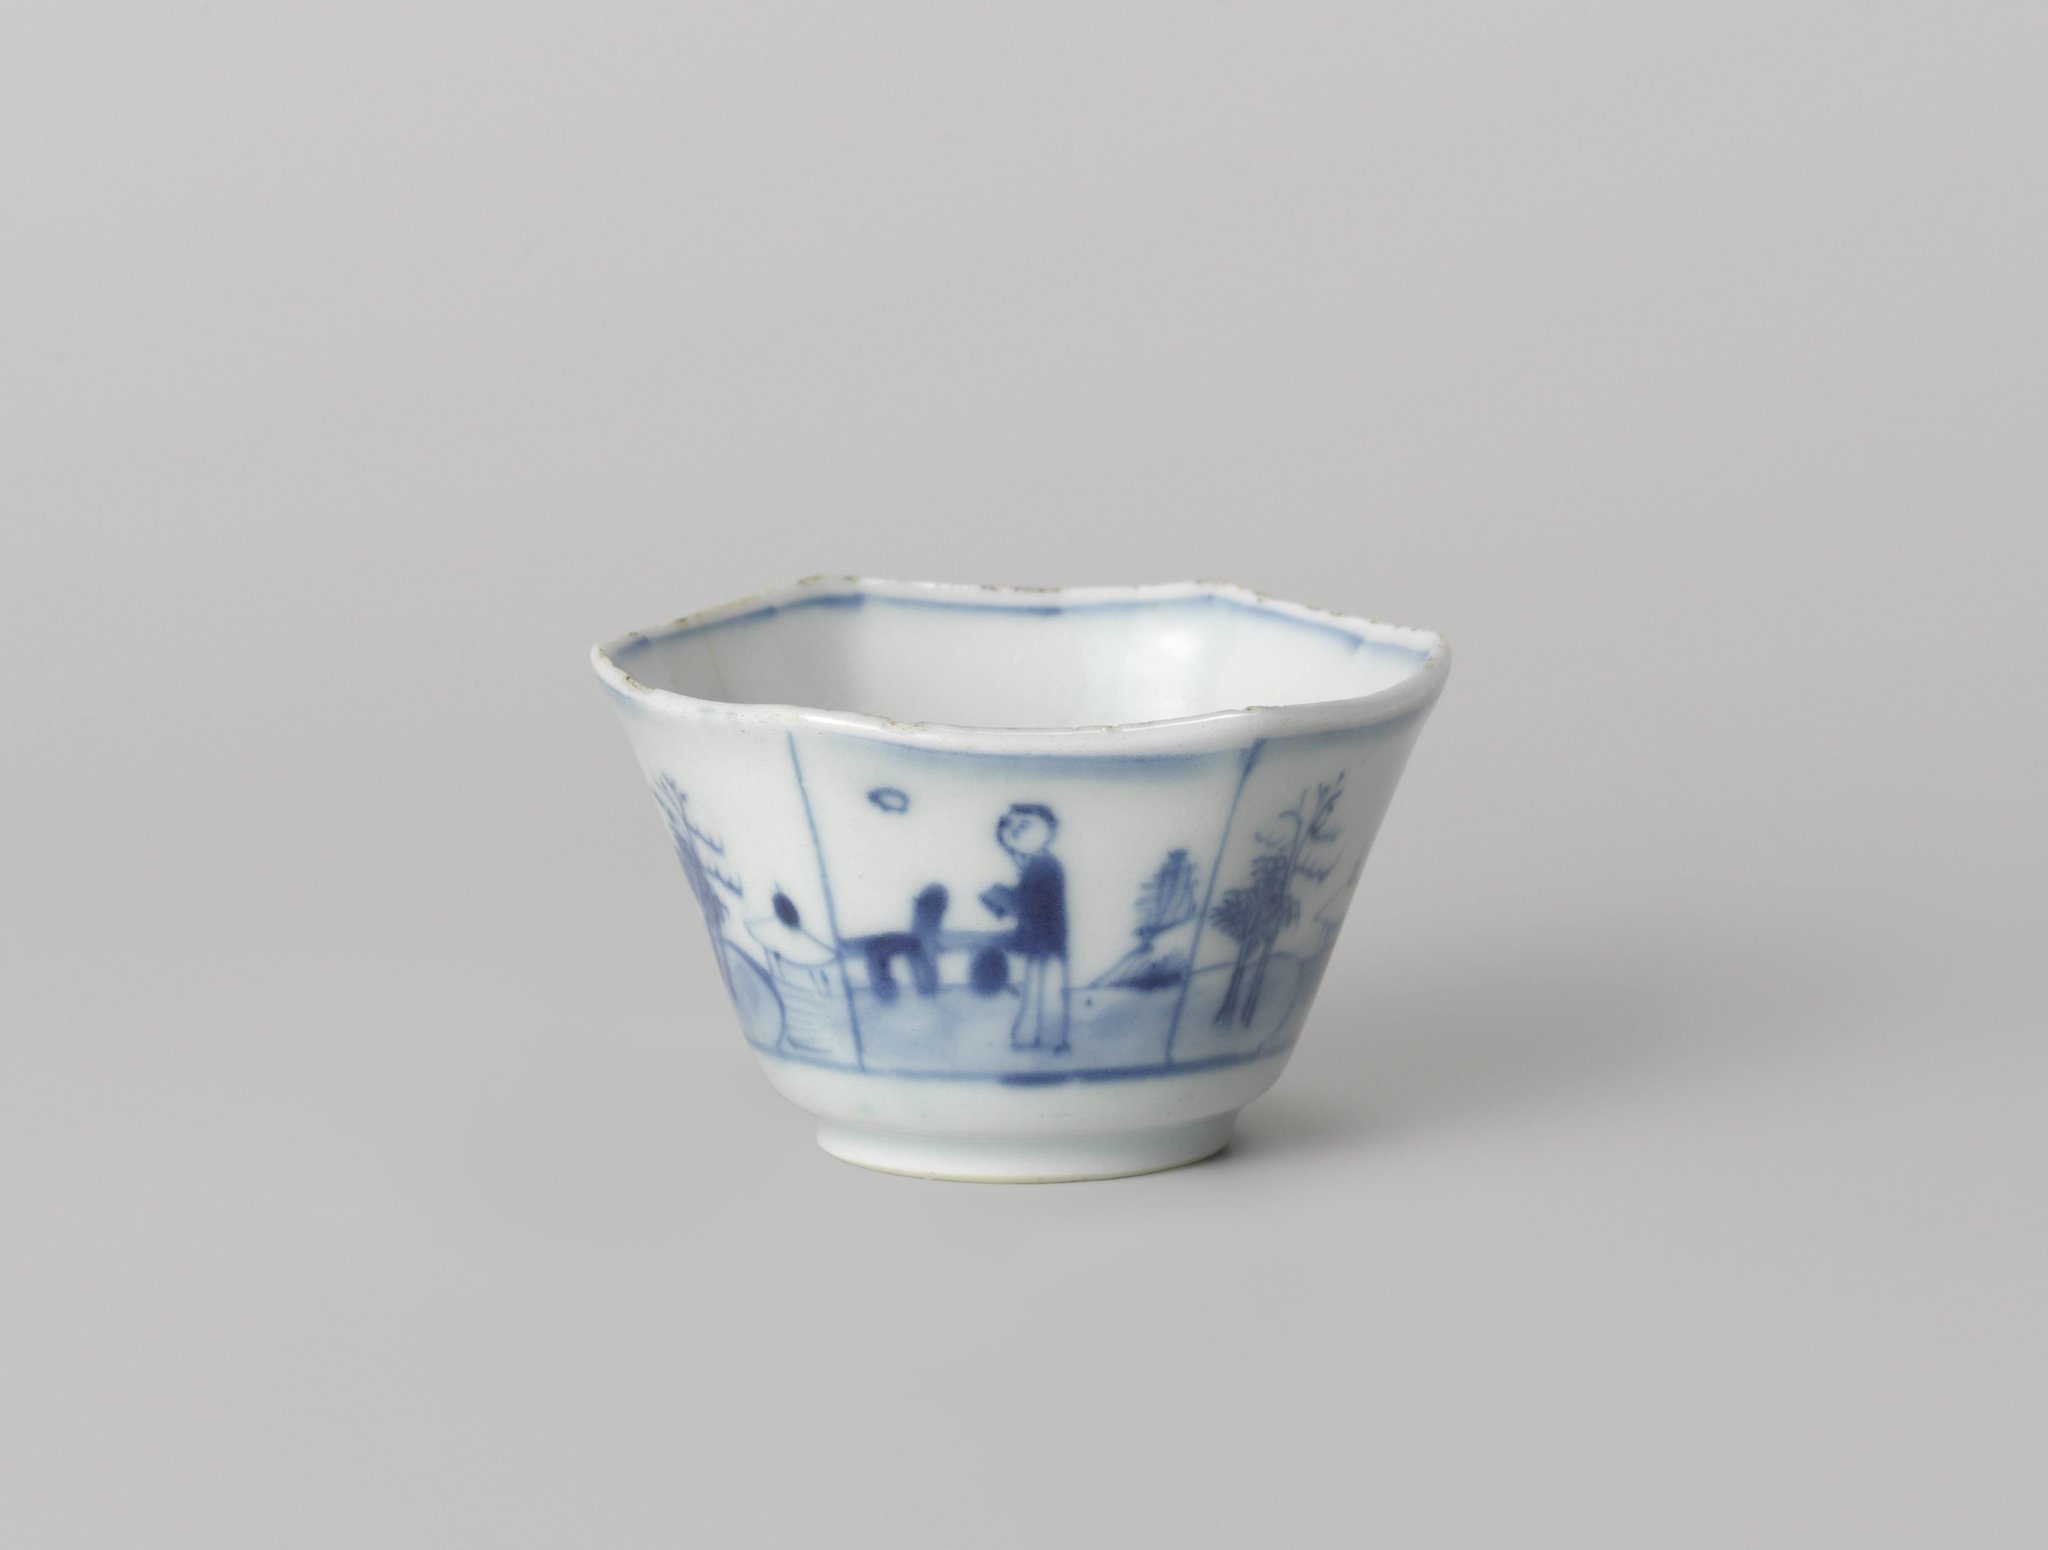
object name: cup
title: Hexagonal cup with landscapes and figures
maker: Anonymous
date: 1750-1774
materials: cobalt, glaze, paint, porcelain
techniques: firing, forming, turning, vitrification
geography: china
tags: landscapes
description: Zeshoekige kop van porselein, beschilderd in onderglazuur blauw. Op de bodem een rivierlandschap met paviljoens, bomen en een persoon; de buitenwand is verdeeld in zes vakken met afwisselend een persoon bij een hek en een rivierlandschap met een paviljoen en bomen. Blauw-wit.